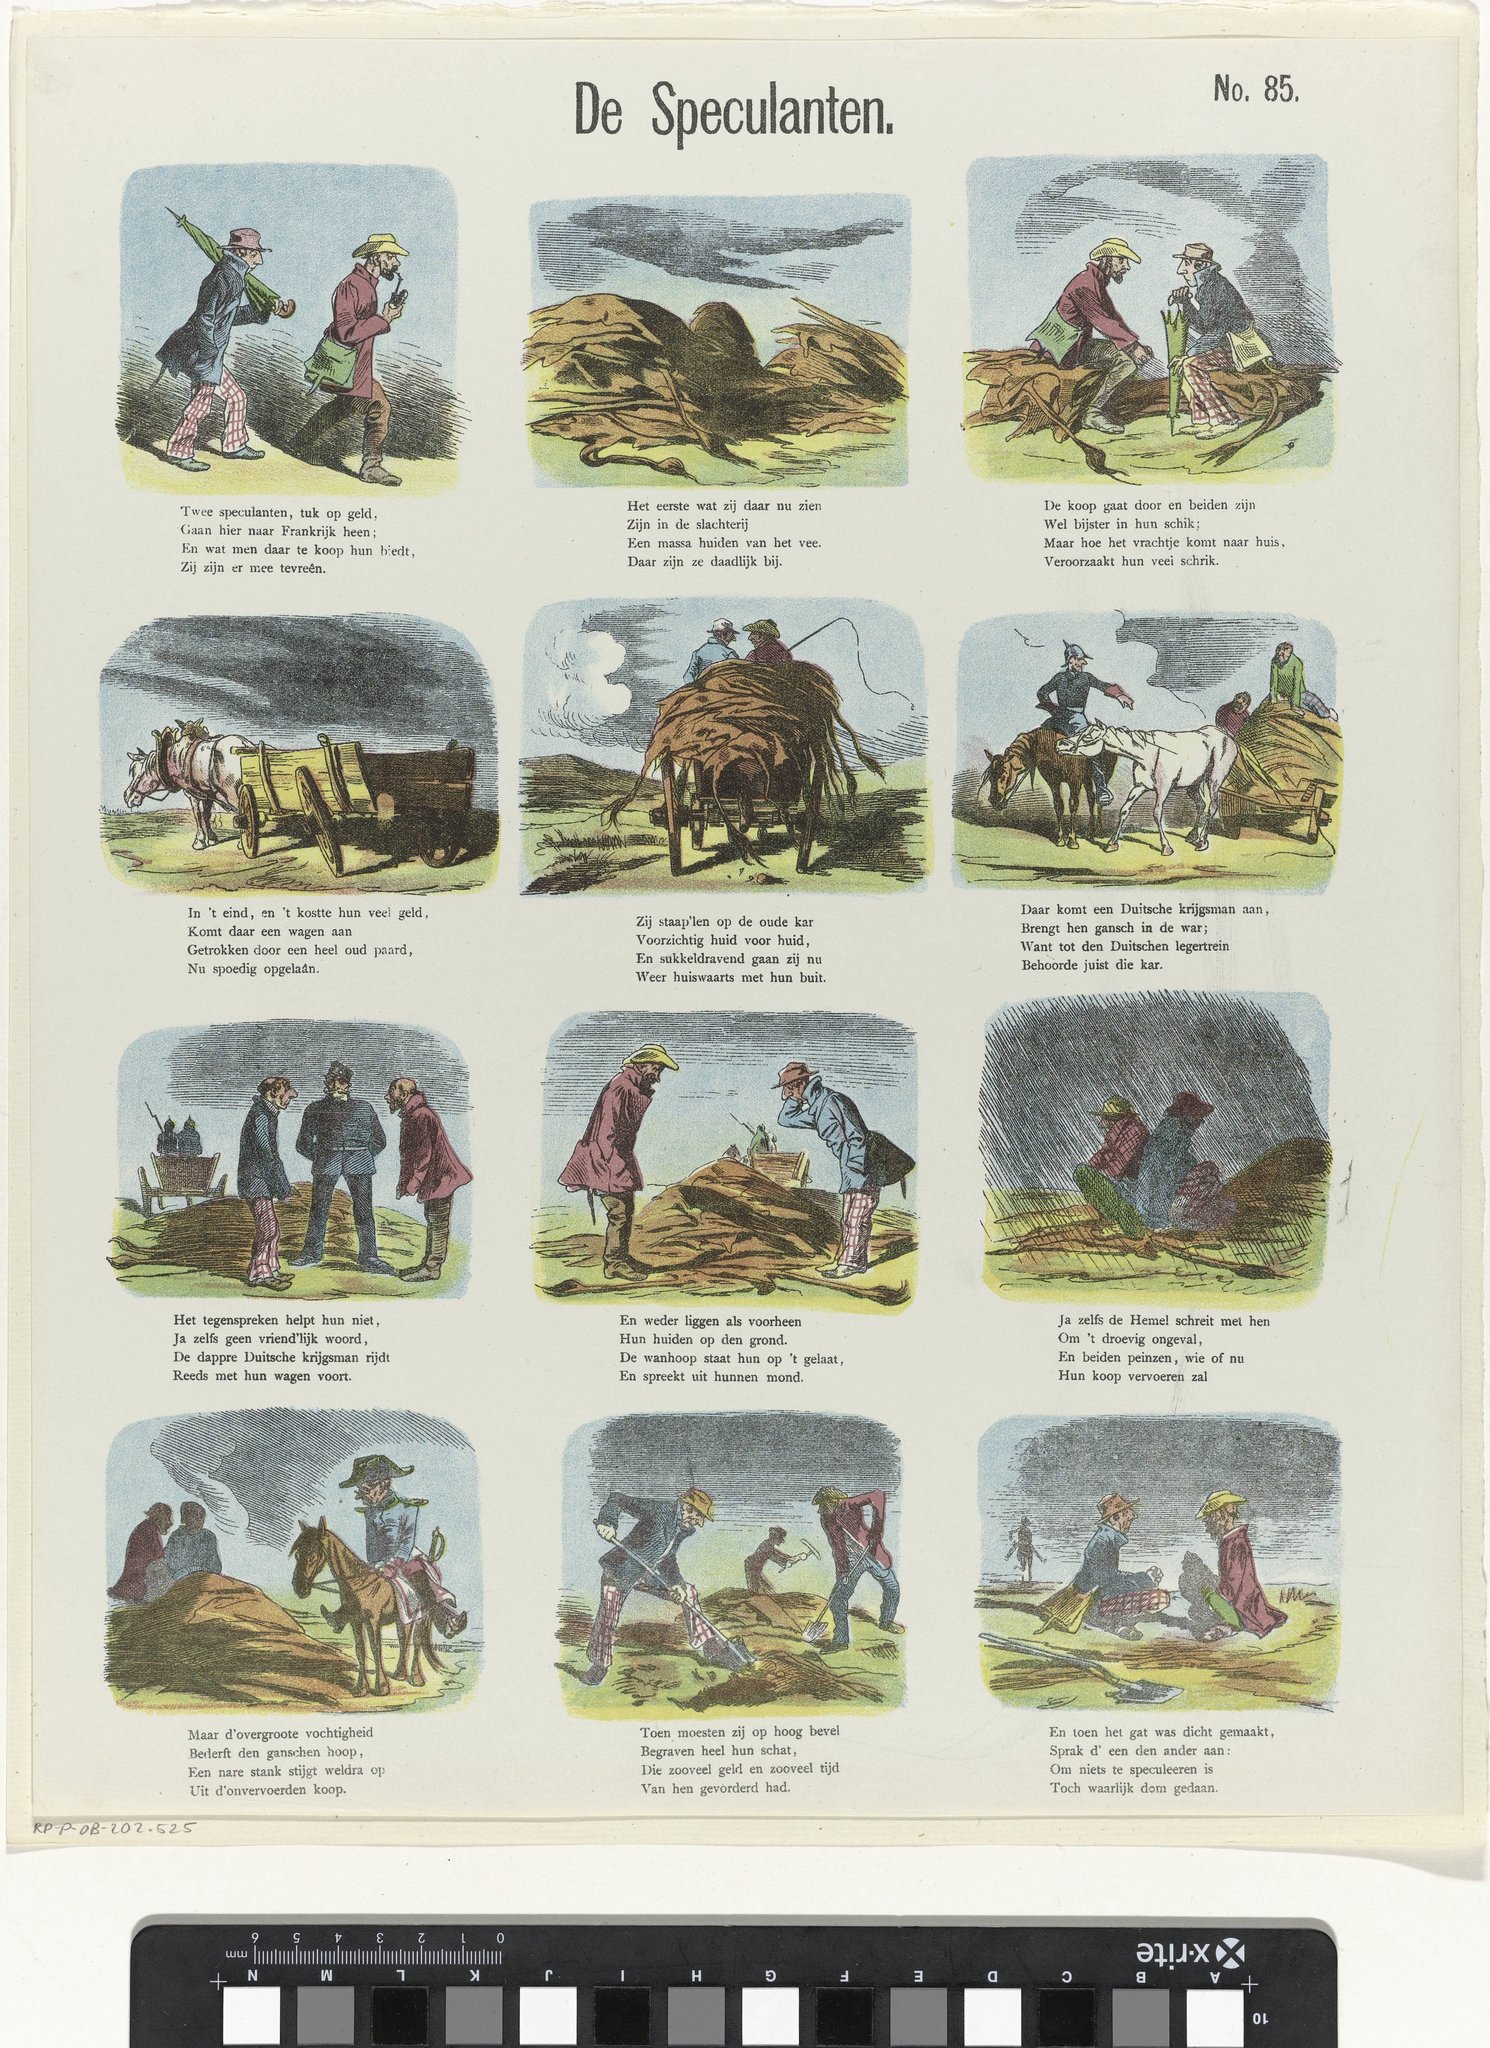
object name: print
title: Meijer's prenten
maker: Anonymous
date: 1881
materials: paper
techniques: lithograph, letterpress printing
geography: amsterdam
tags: animals (+ skin, fleece, hide, fur, leather), street-trader, merchant, salesman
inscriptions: collector's mark: Lugt 2760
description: Blad met 12 voorstellingen over twee mannen die een partij dierenhuiden kopen maar deze niet kunnen vervoeren. Onder elke afbeelding een vierregelig vers. Genummerd rechtsboven: No. 85.